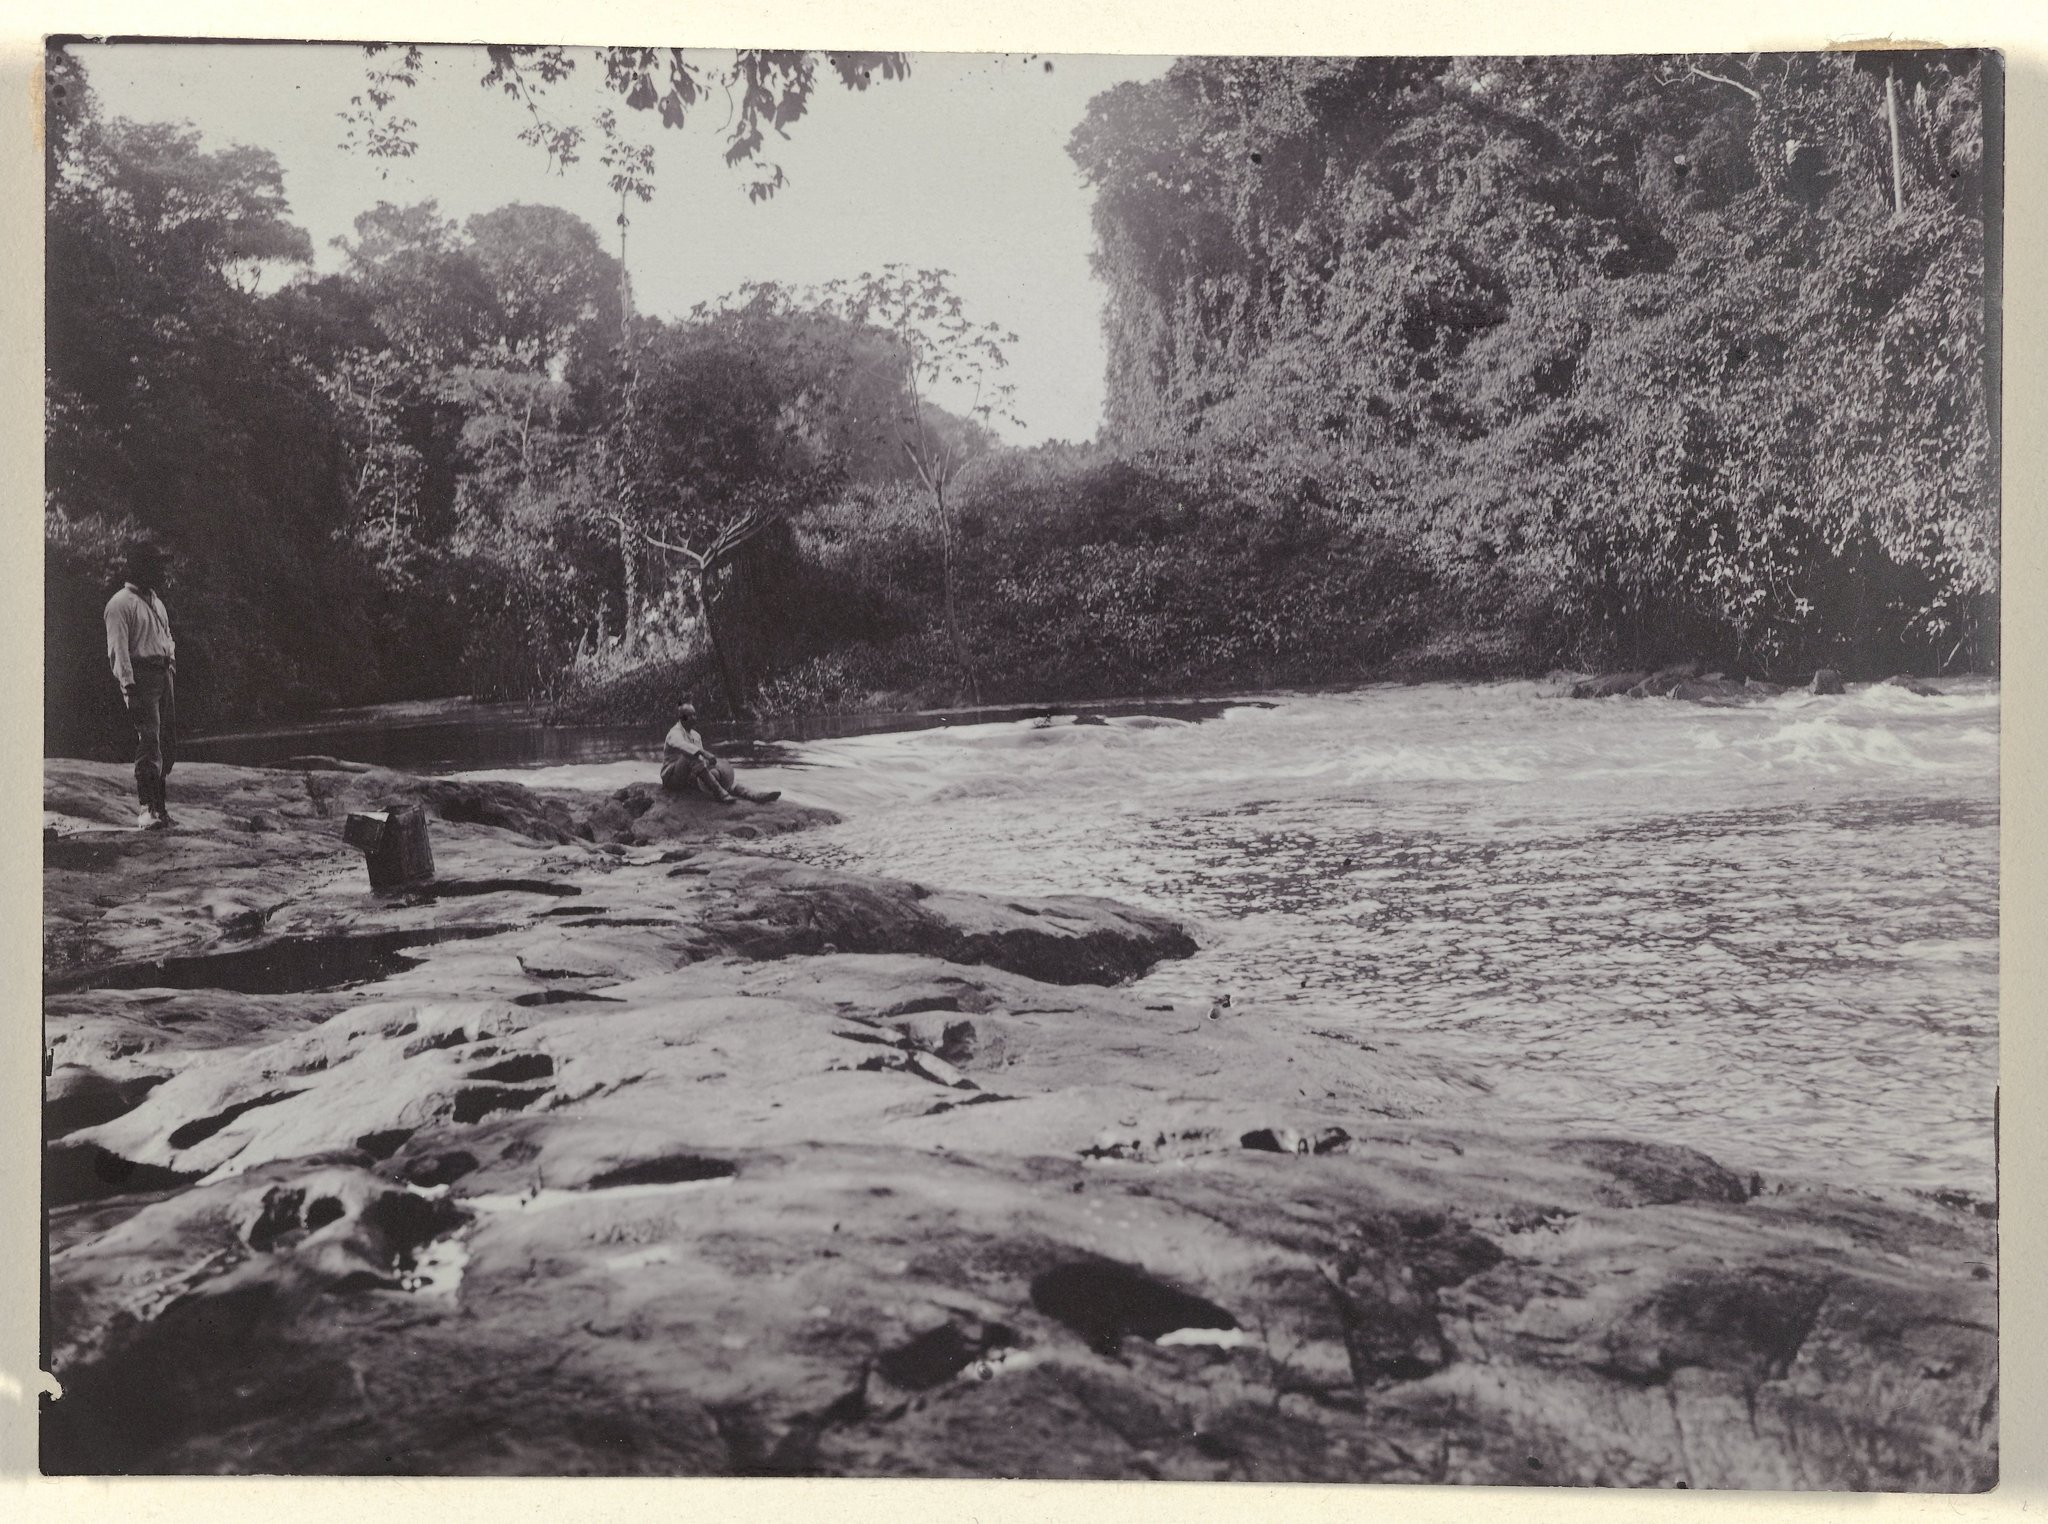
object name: photograph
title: Rivieroever in Suriname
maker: Anonymous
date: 1900-1910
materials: photographic support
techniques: photography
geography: suriname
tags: landscapes in tropical and sub-tropical regions, suriname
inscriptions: annotation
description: Rivierbedding in de buurt van het dorp Gégé in Suriname met twee personen aan de waterkant. Onderdeel van een groep objecten afkomstig van de familie Wesenhagen in Suriname.